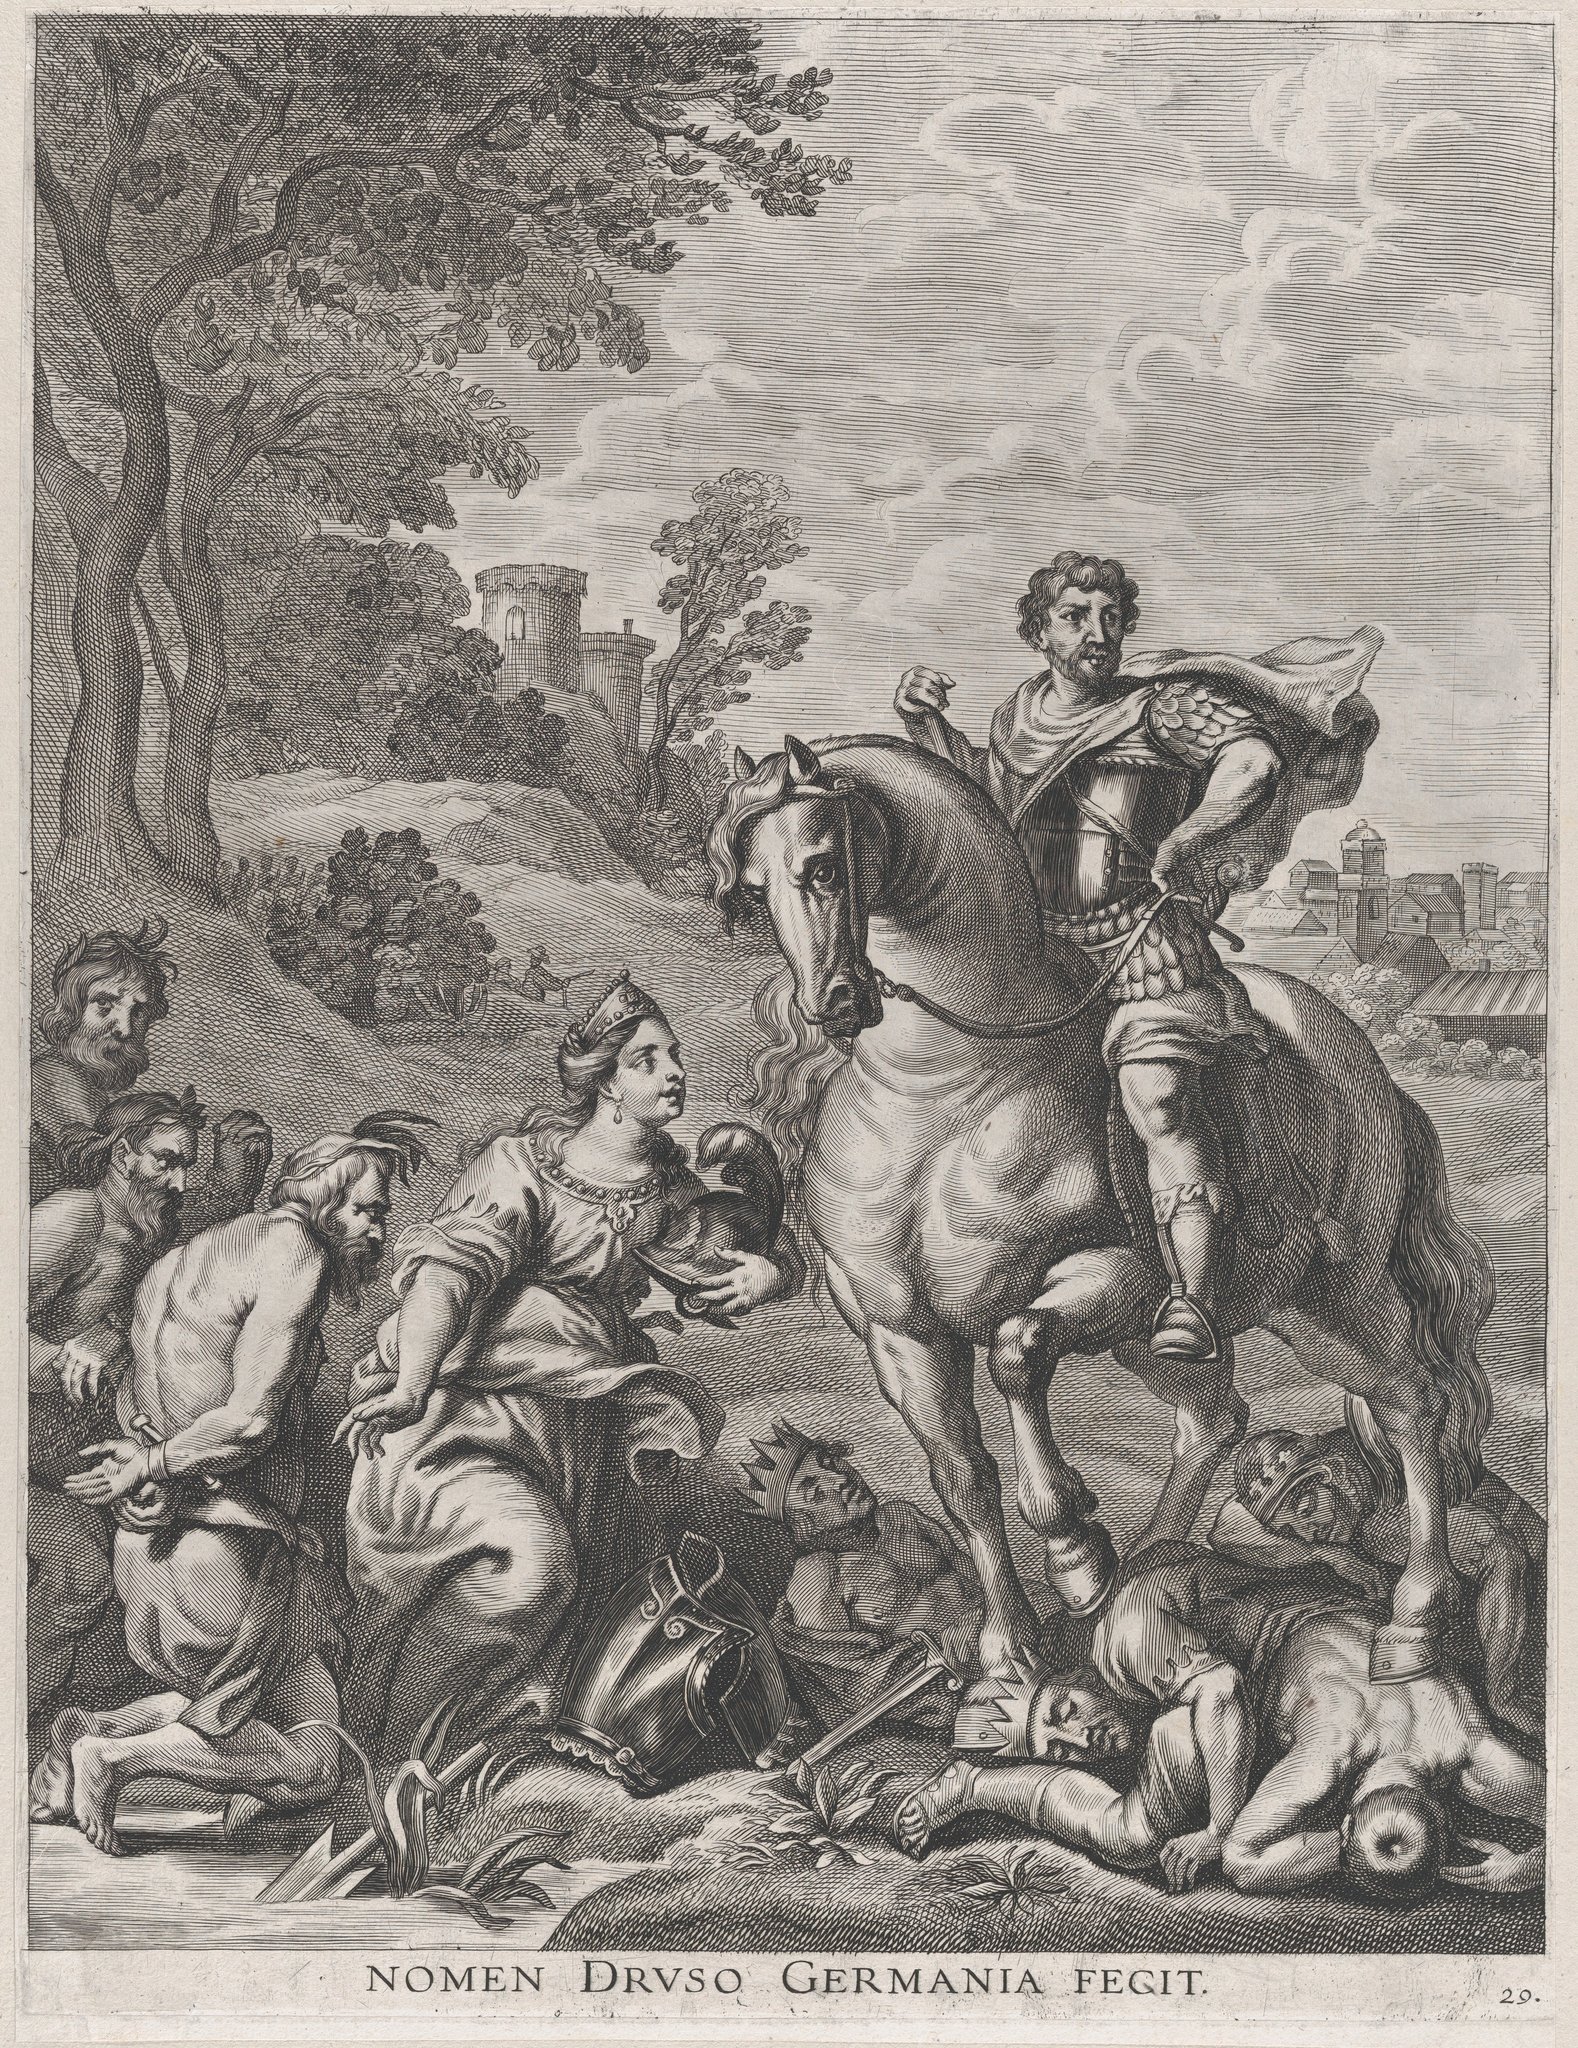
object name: print, fete, ornament architecture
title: Plate 29: Germany conquered by Drusus; from Guillielmus Becanus's 'Serenissimi Principis Ferdinandi, Hispaniarum Infantis...'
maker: jacob neeffs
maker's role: artist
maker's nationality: flemish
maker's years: 1610-1670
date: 1636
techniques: engraving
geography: antwerp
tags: princes,horses